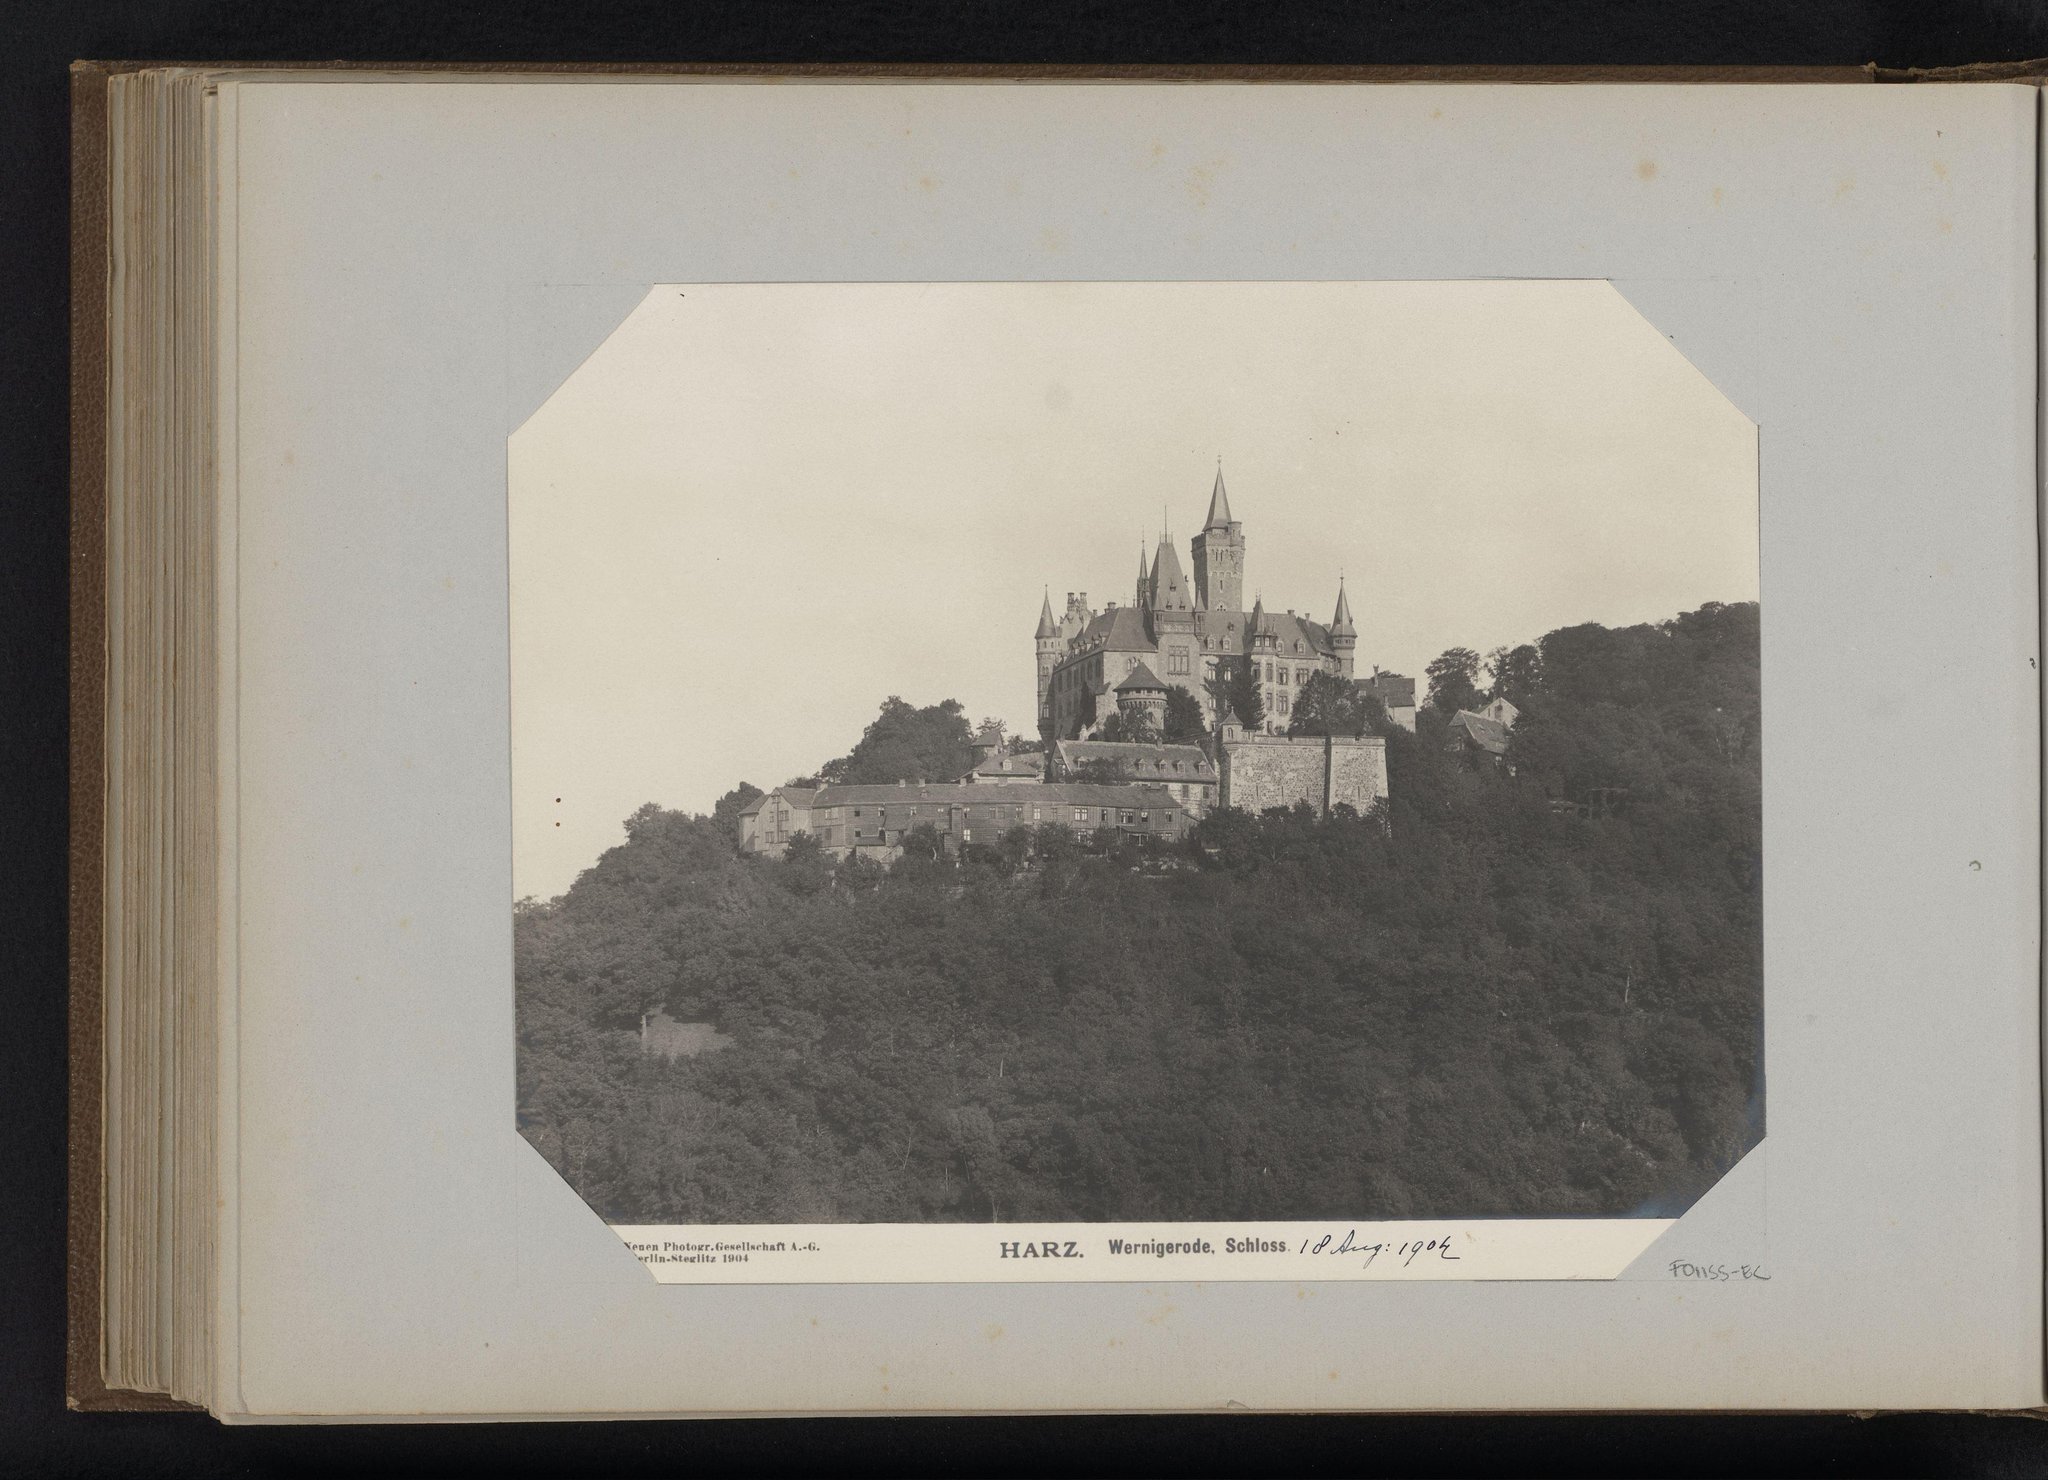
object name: album leaf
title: Gezicht op kasteel Wernigerode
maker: Anonymous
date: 1904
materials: photographic support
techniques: gelatin silver print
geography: wernigerode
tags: landscape with tower or castle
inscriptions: inscription: ‘Verlag der Neuen Photogr. Gesellschaft A.-G./ Berlin-Steglitz 1904/ Harz. Wernigerode, Schloss/ 1635’, annotation: ‘18 Aug: 1902’